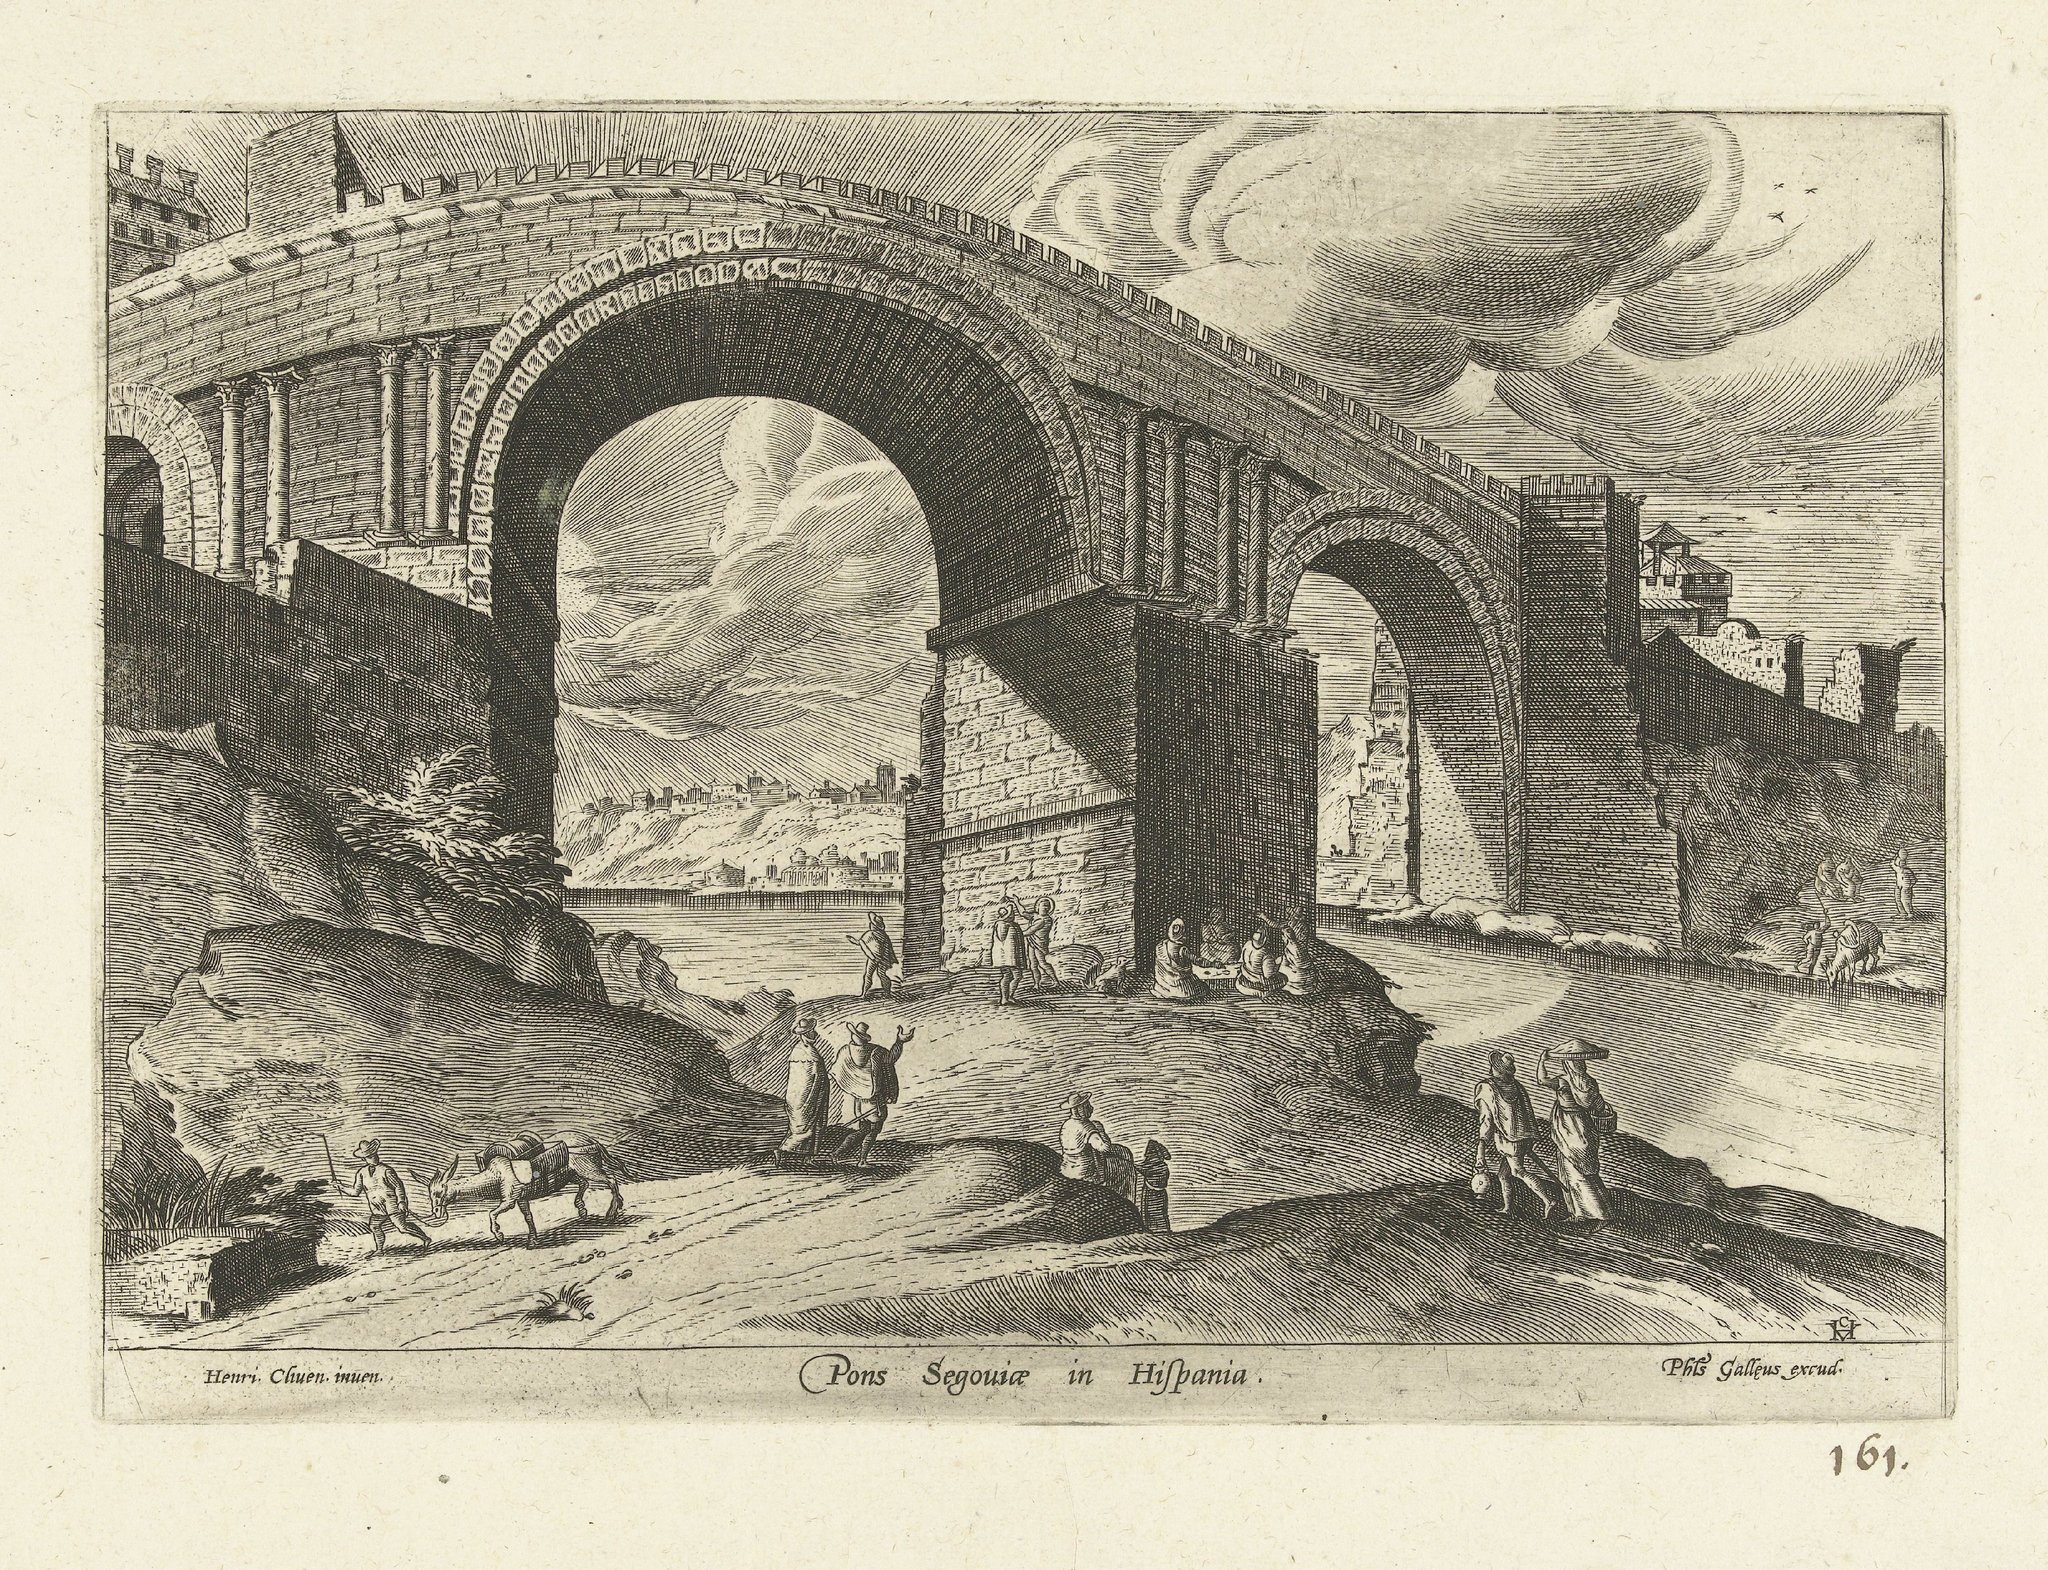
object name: print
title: Gezicht op een brug van de stad Segovia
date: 1585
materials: paper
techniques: engraving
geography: antwerp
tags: landscape with bridge, viaduct or aqueduct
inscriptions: collector's mark: Lugt 2228, number: ‘161’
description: Gezicht op een brug van de stad Segovia. Onderaan de brug verschillende wandelaars. De prent is deel van een serie die verschillende plaatsen in het Middellandse Zeegebied afbeeldt.